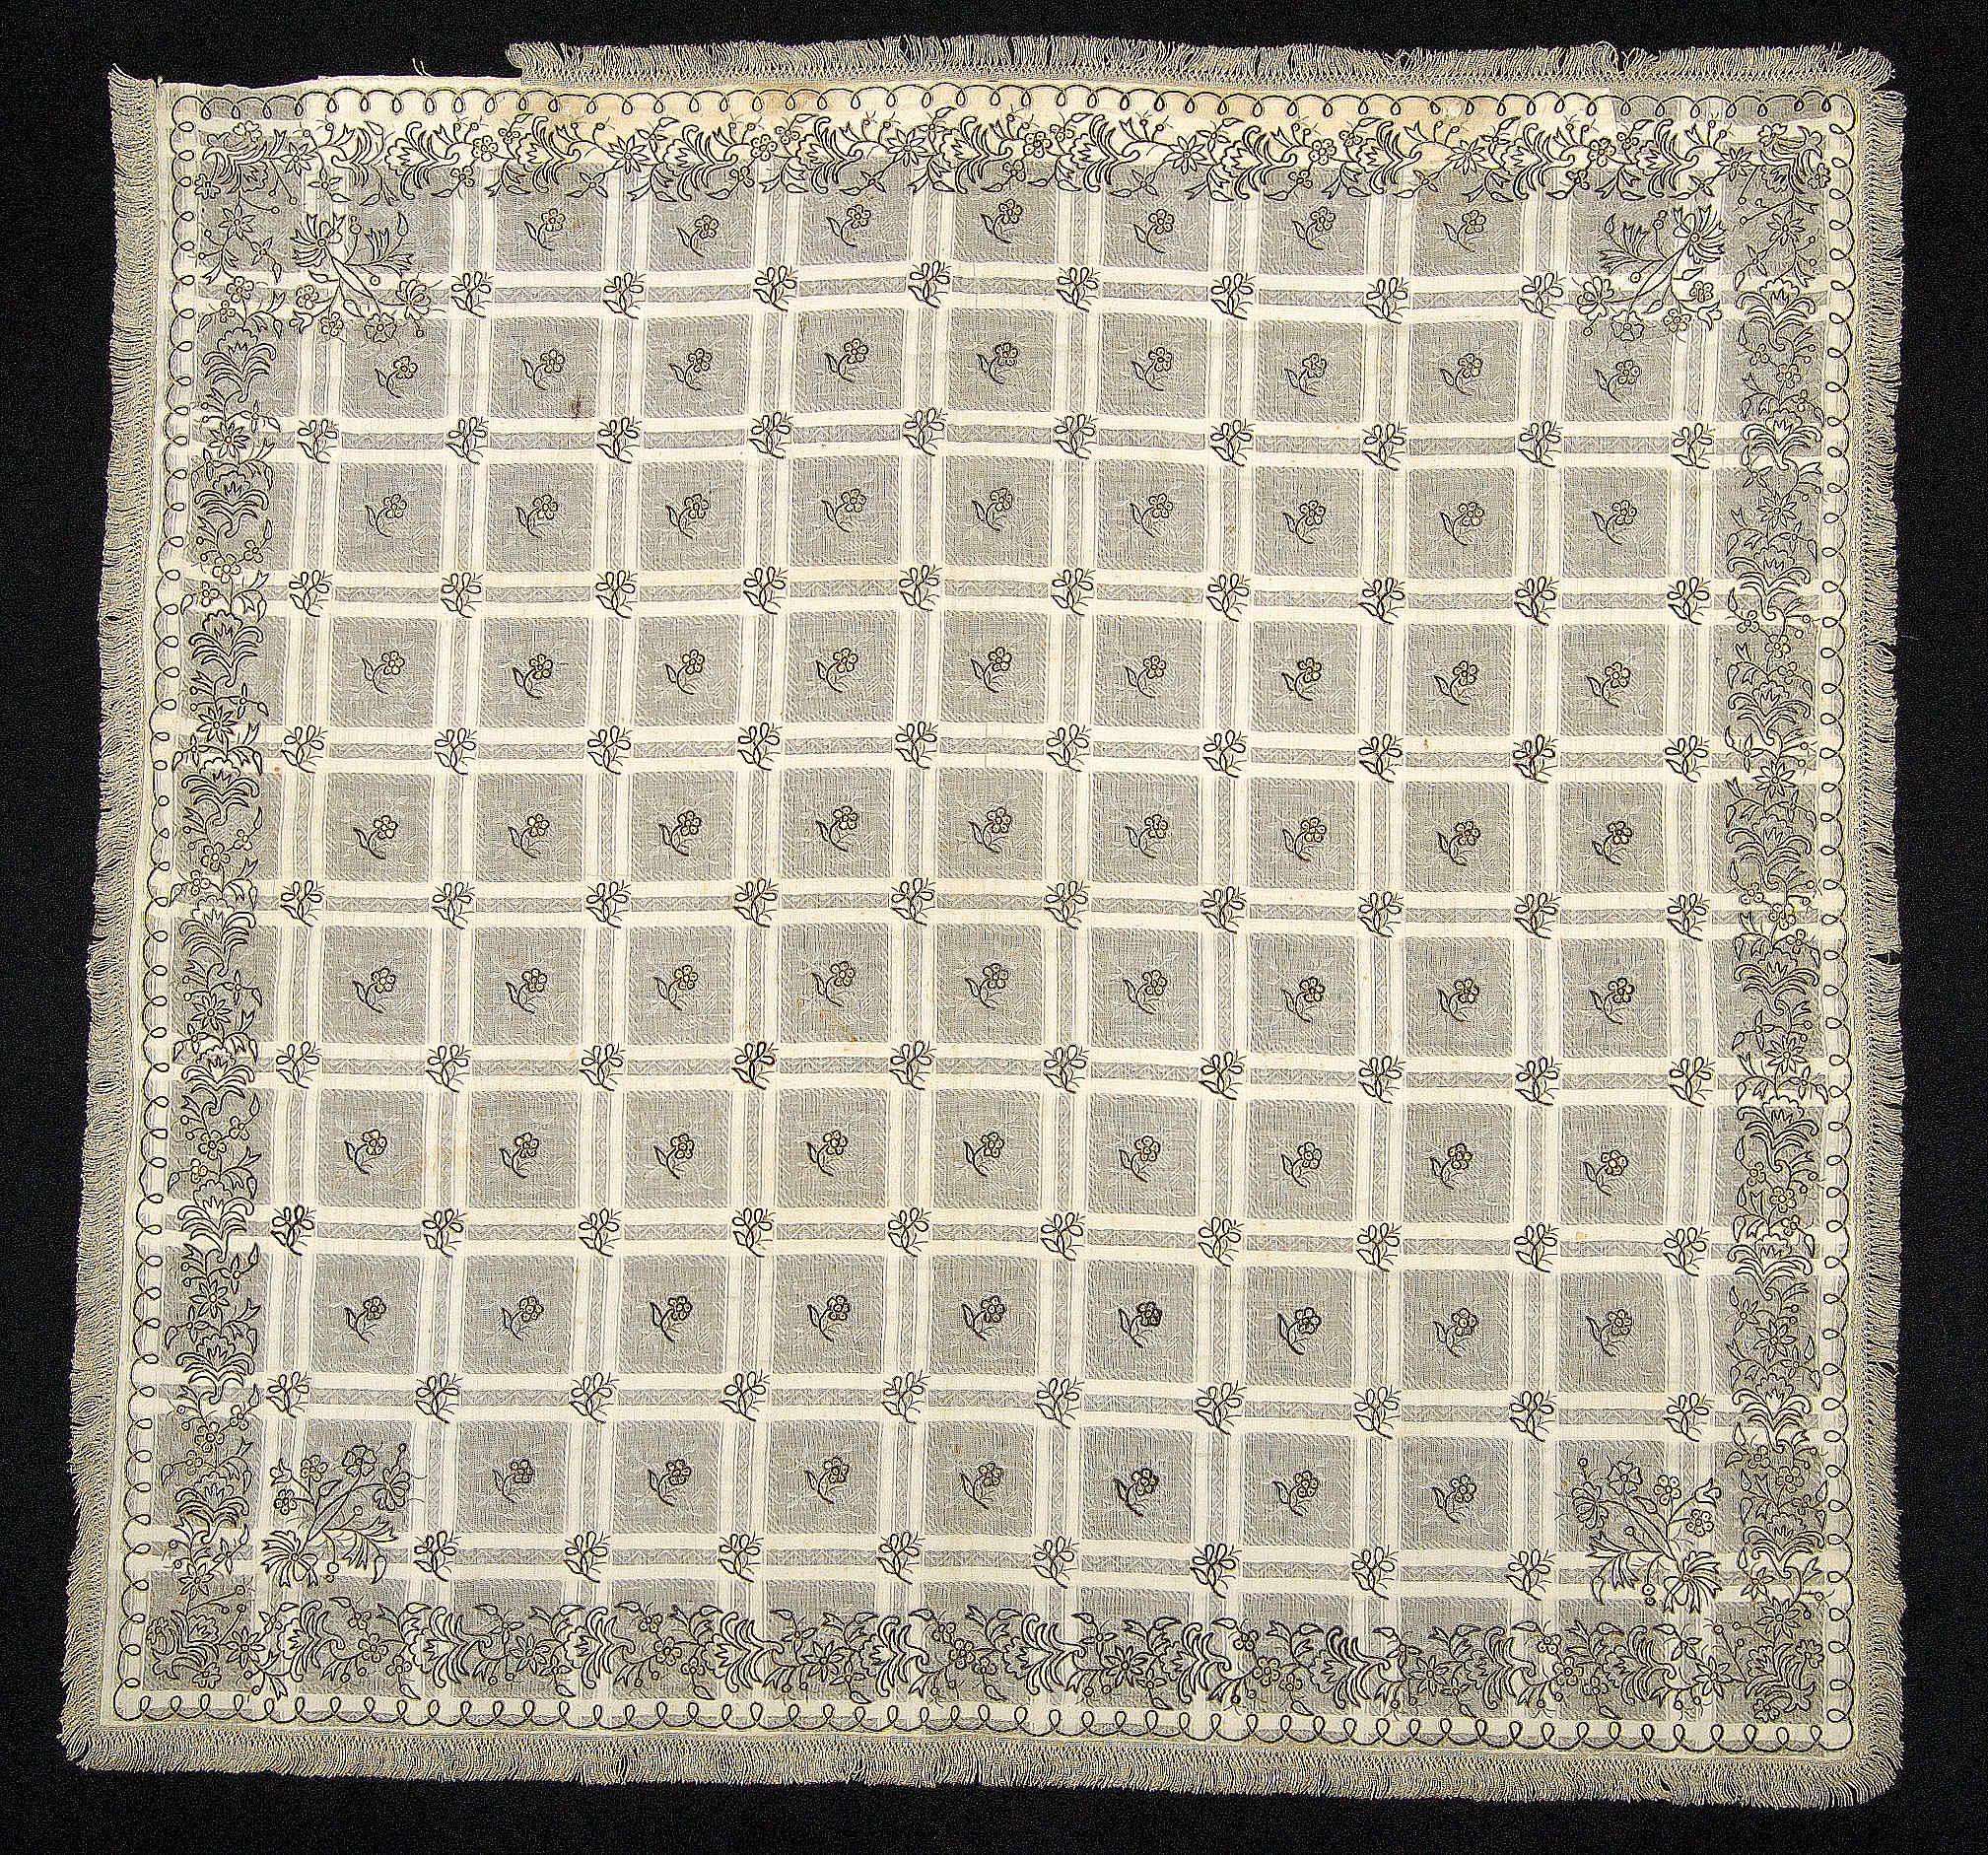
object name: headscarf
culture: russian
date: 1800-1850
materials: cotton